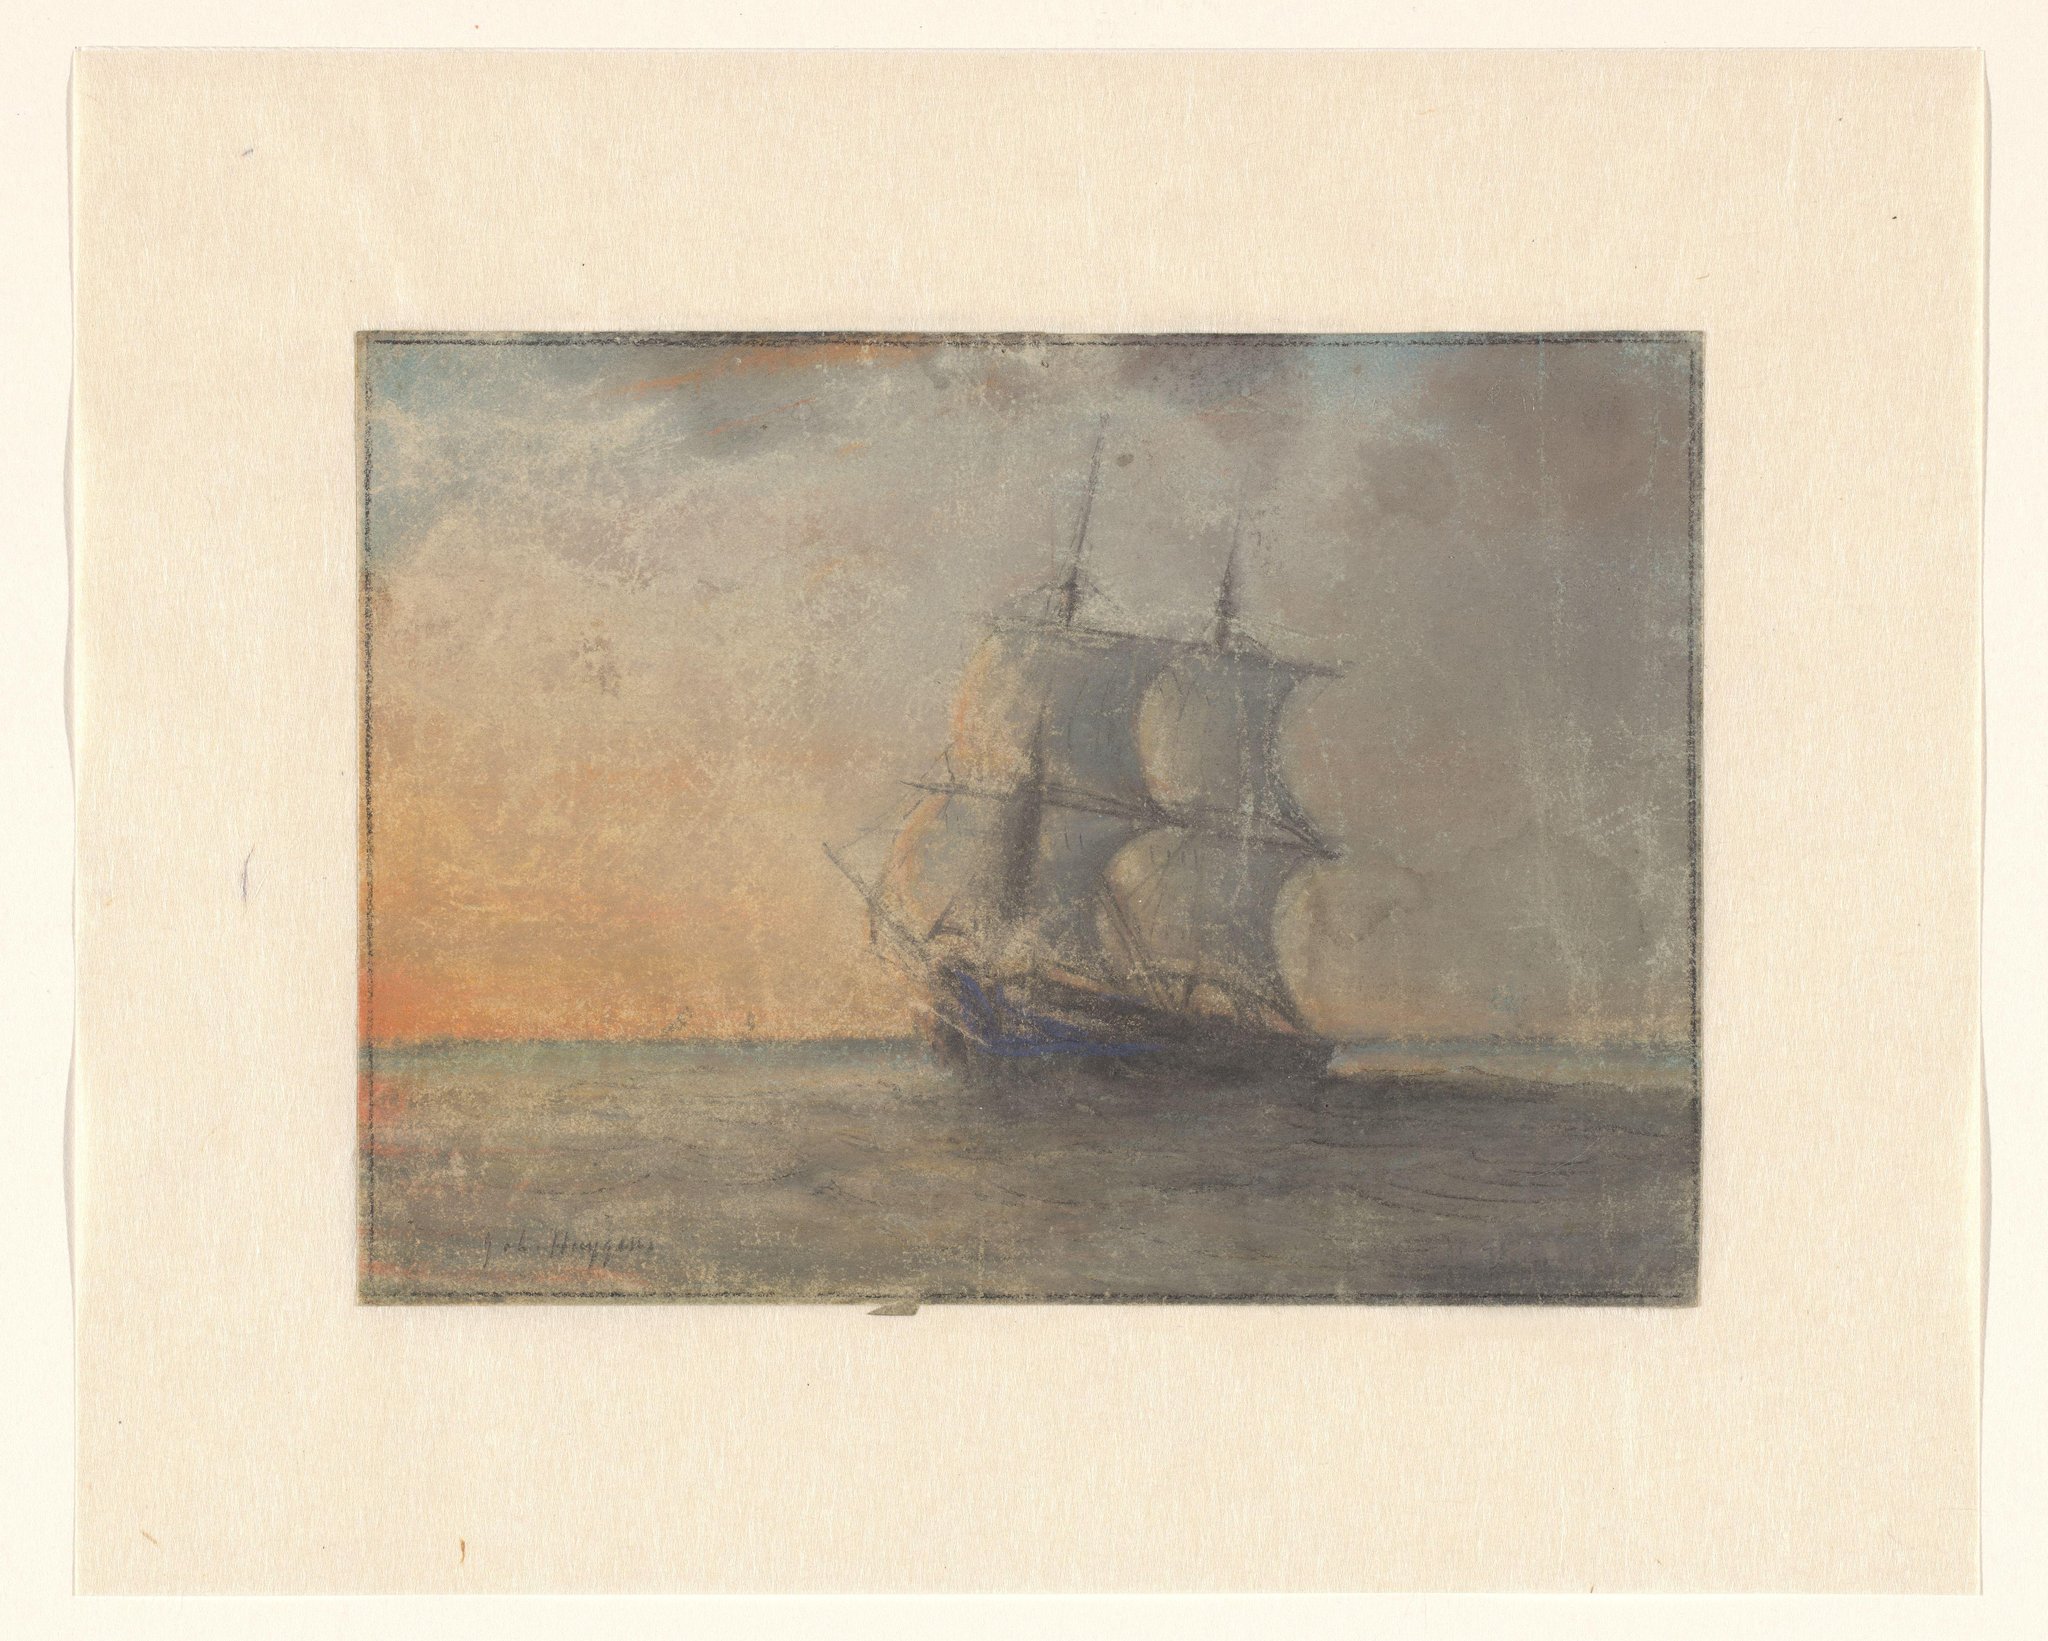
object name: drawing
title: Tweemaster op zee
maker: johannes huygens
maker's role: draughtsman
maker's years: 1833-1911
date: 1843-1911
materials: paper, pastel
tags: sailing-ship, sailing-boat